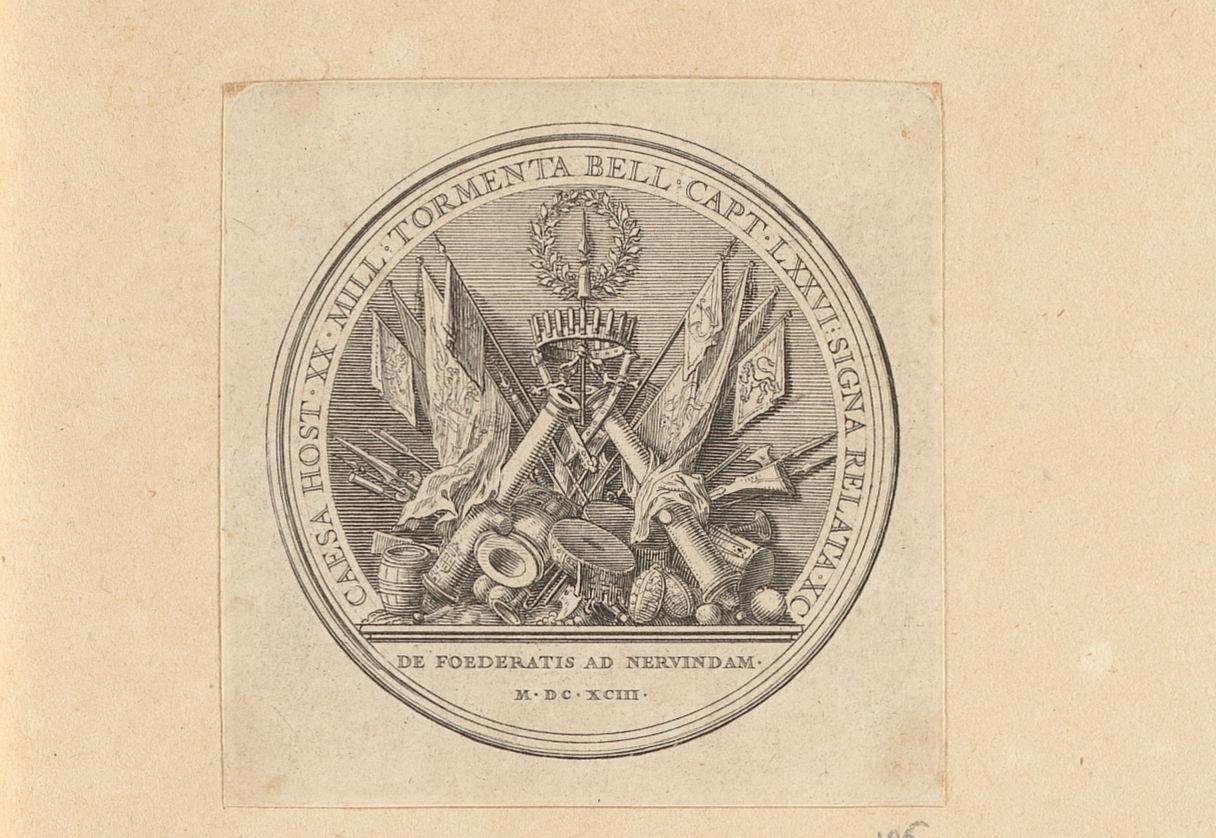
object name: album leaf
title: Caesa Host XX MILL Tormenta Bell Capt (...)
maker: sébastien leclerc (i)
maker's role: print maker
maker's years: 1637-1714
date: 1702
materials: paper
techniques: etching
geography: paris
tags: lodewijk xiv (koning van frankrijk), historical persons, trophy ~ battle, war, medal (considered as a piece of sculpture, regardless of its specific function), king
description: Prent bestemd voor: Médailles sur les principaux événements du règne de Louis le Grand. Parijs: Imprimerie Royale, 1702.